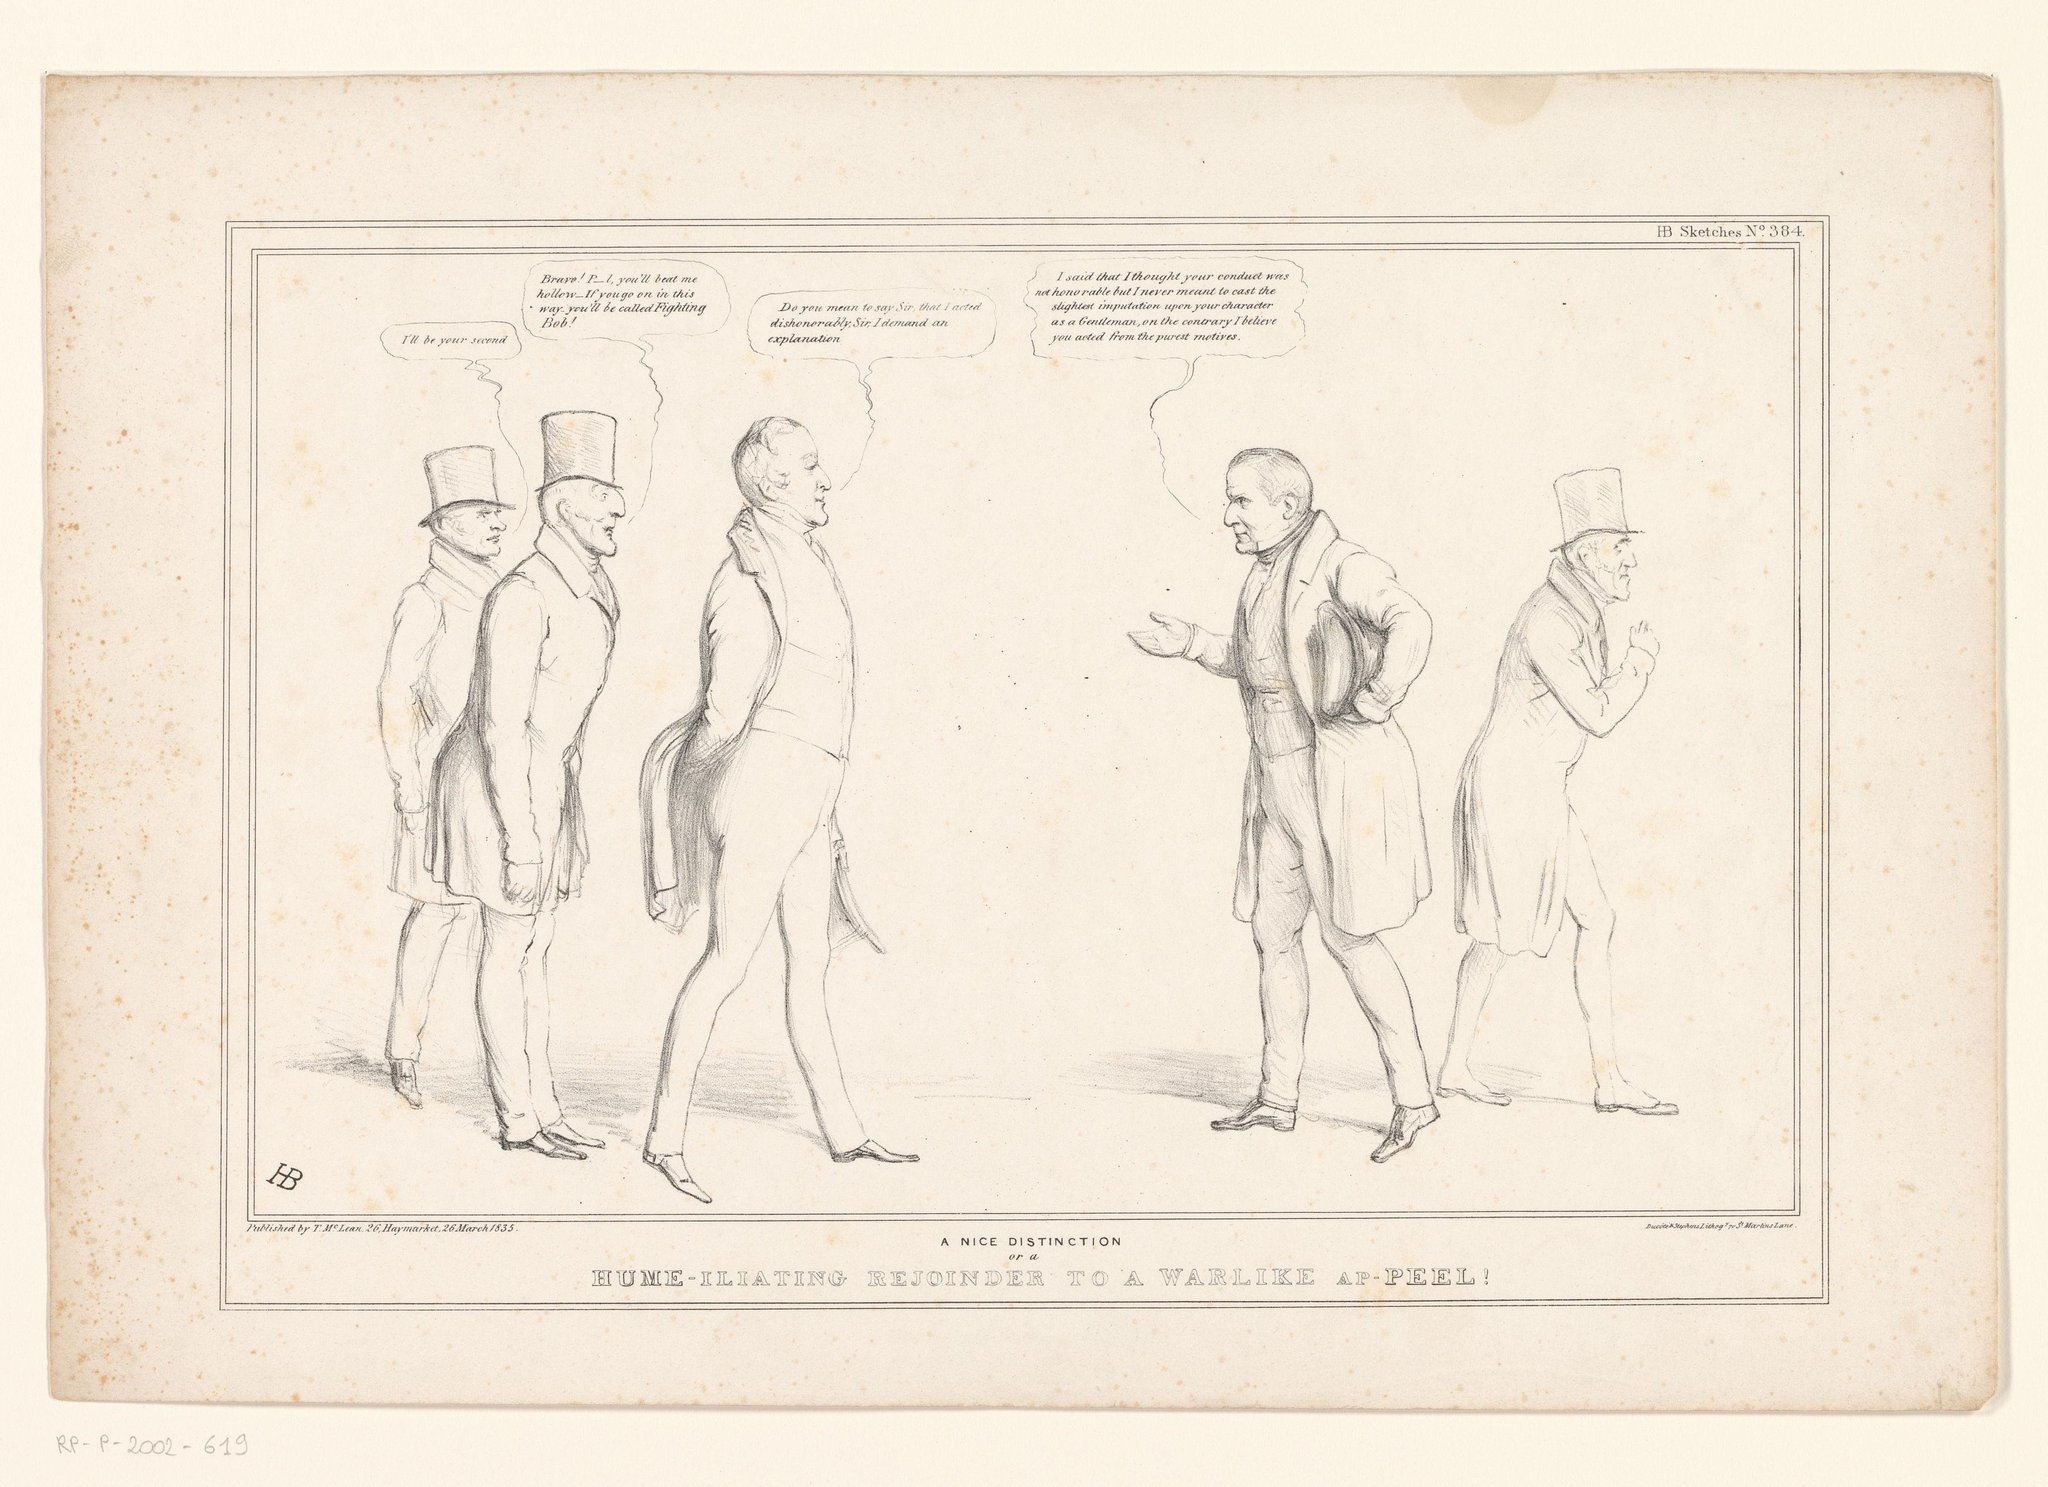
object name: print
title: A nice distinction or a Hume-iliating rejoinder to a warlike ap-Peel!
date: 1835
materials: paper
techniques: lithograph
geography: london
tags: political caricatures and satires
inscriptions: collector's mark: Lugt 2228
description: Spotprent met centraal Sir Robert Peel en Joseph Hume. Uitgegeven als nr. 384 in de serie HB Sketches.